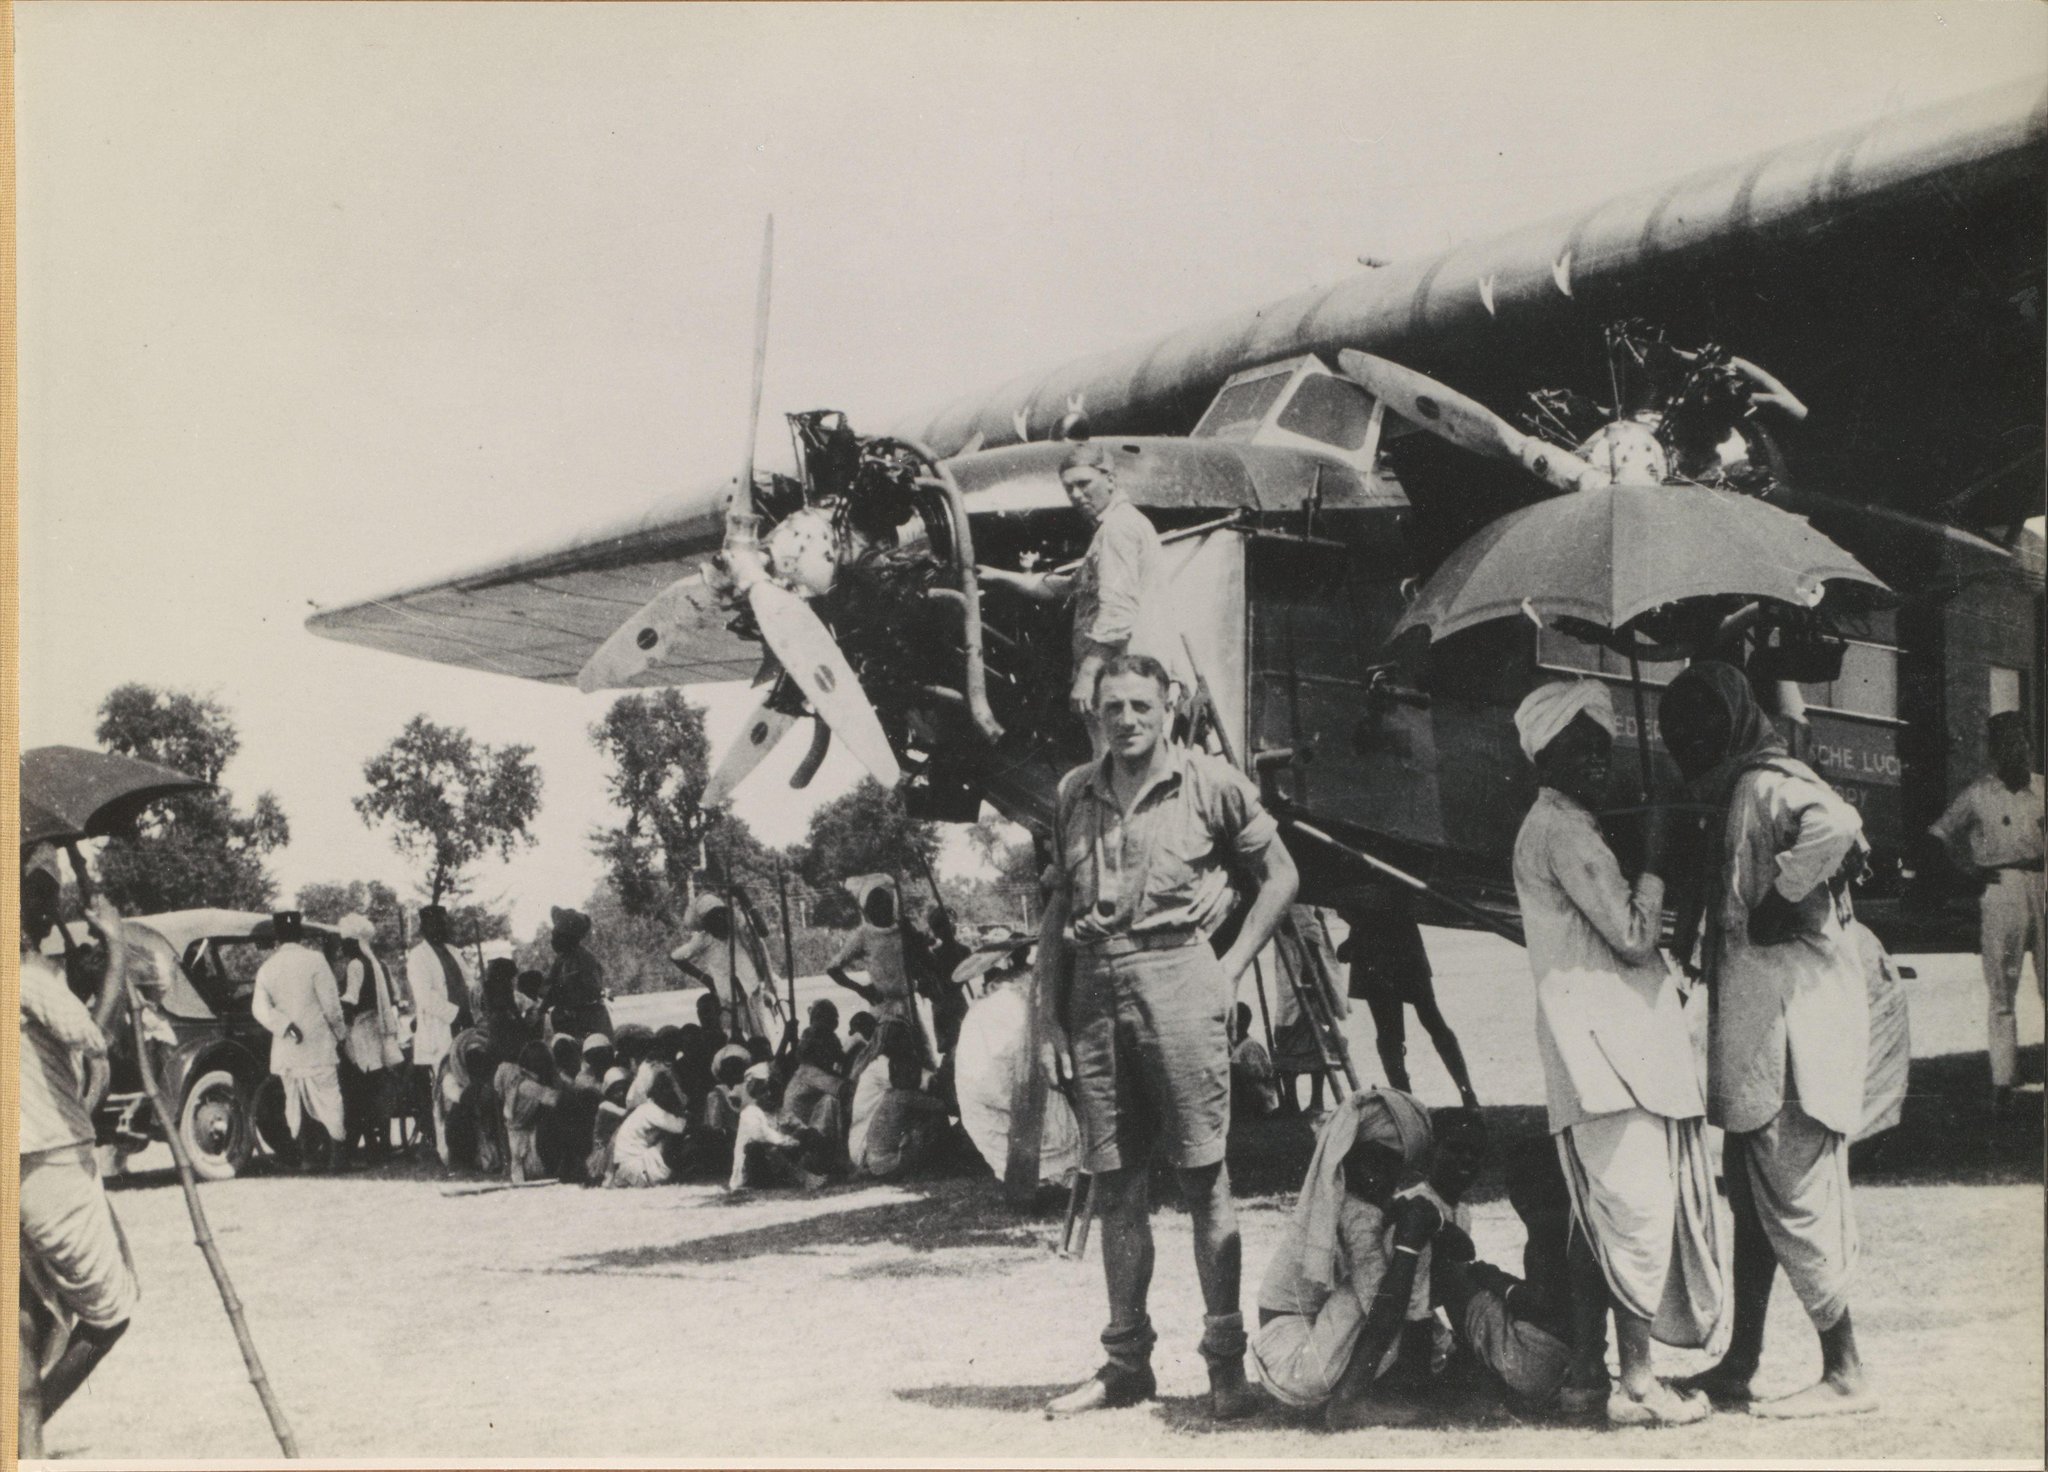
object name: album leaf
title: Vliegtuig in het Midden-Oosten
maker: Anonymous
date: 1925-1935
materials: cardboard, paper, photographic support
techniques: gelatin silver print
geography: middle east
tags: aircraft, aeroplane, airborne traffic, aviation, pilot, flight crew, travelling; tourism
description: Albumblad met een foto van een KLM-vliegtuig omringd door bemanning en toeschouwers, vermoedelijk in het Midden-Oosten. Onderdeel van Herdenkingsalbum van de Indië-lijn van de KLM, deel I.